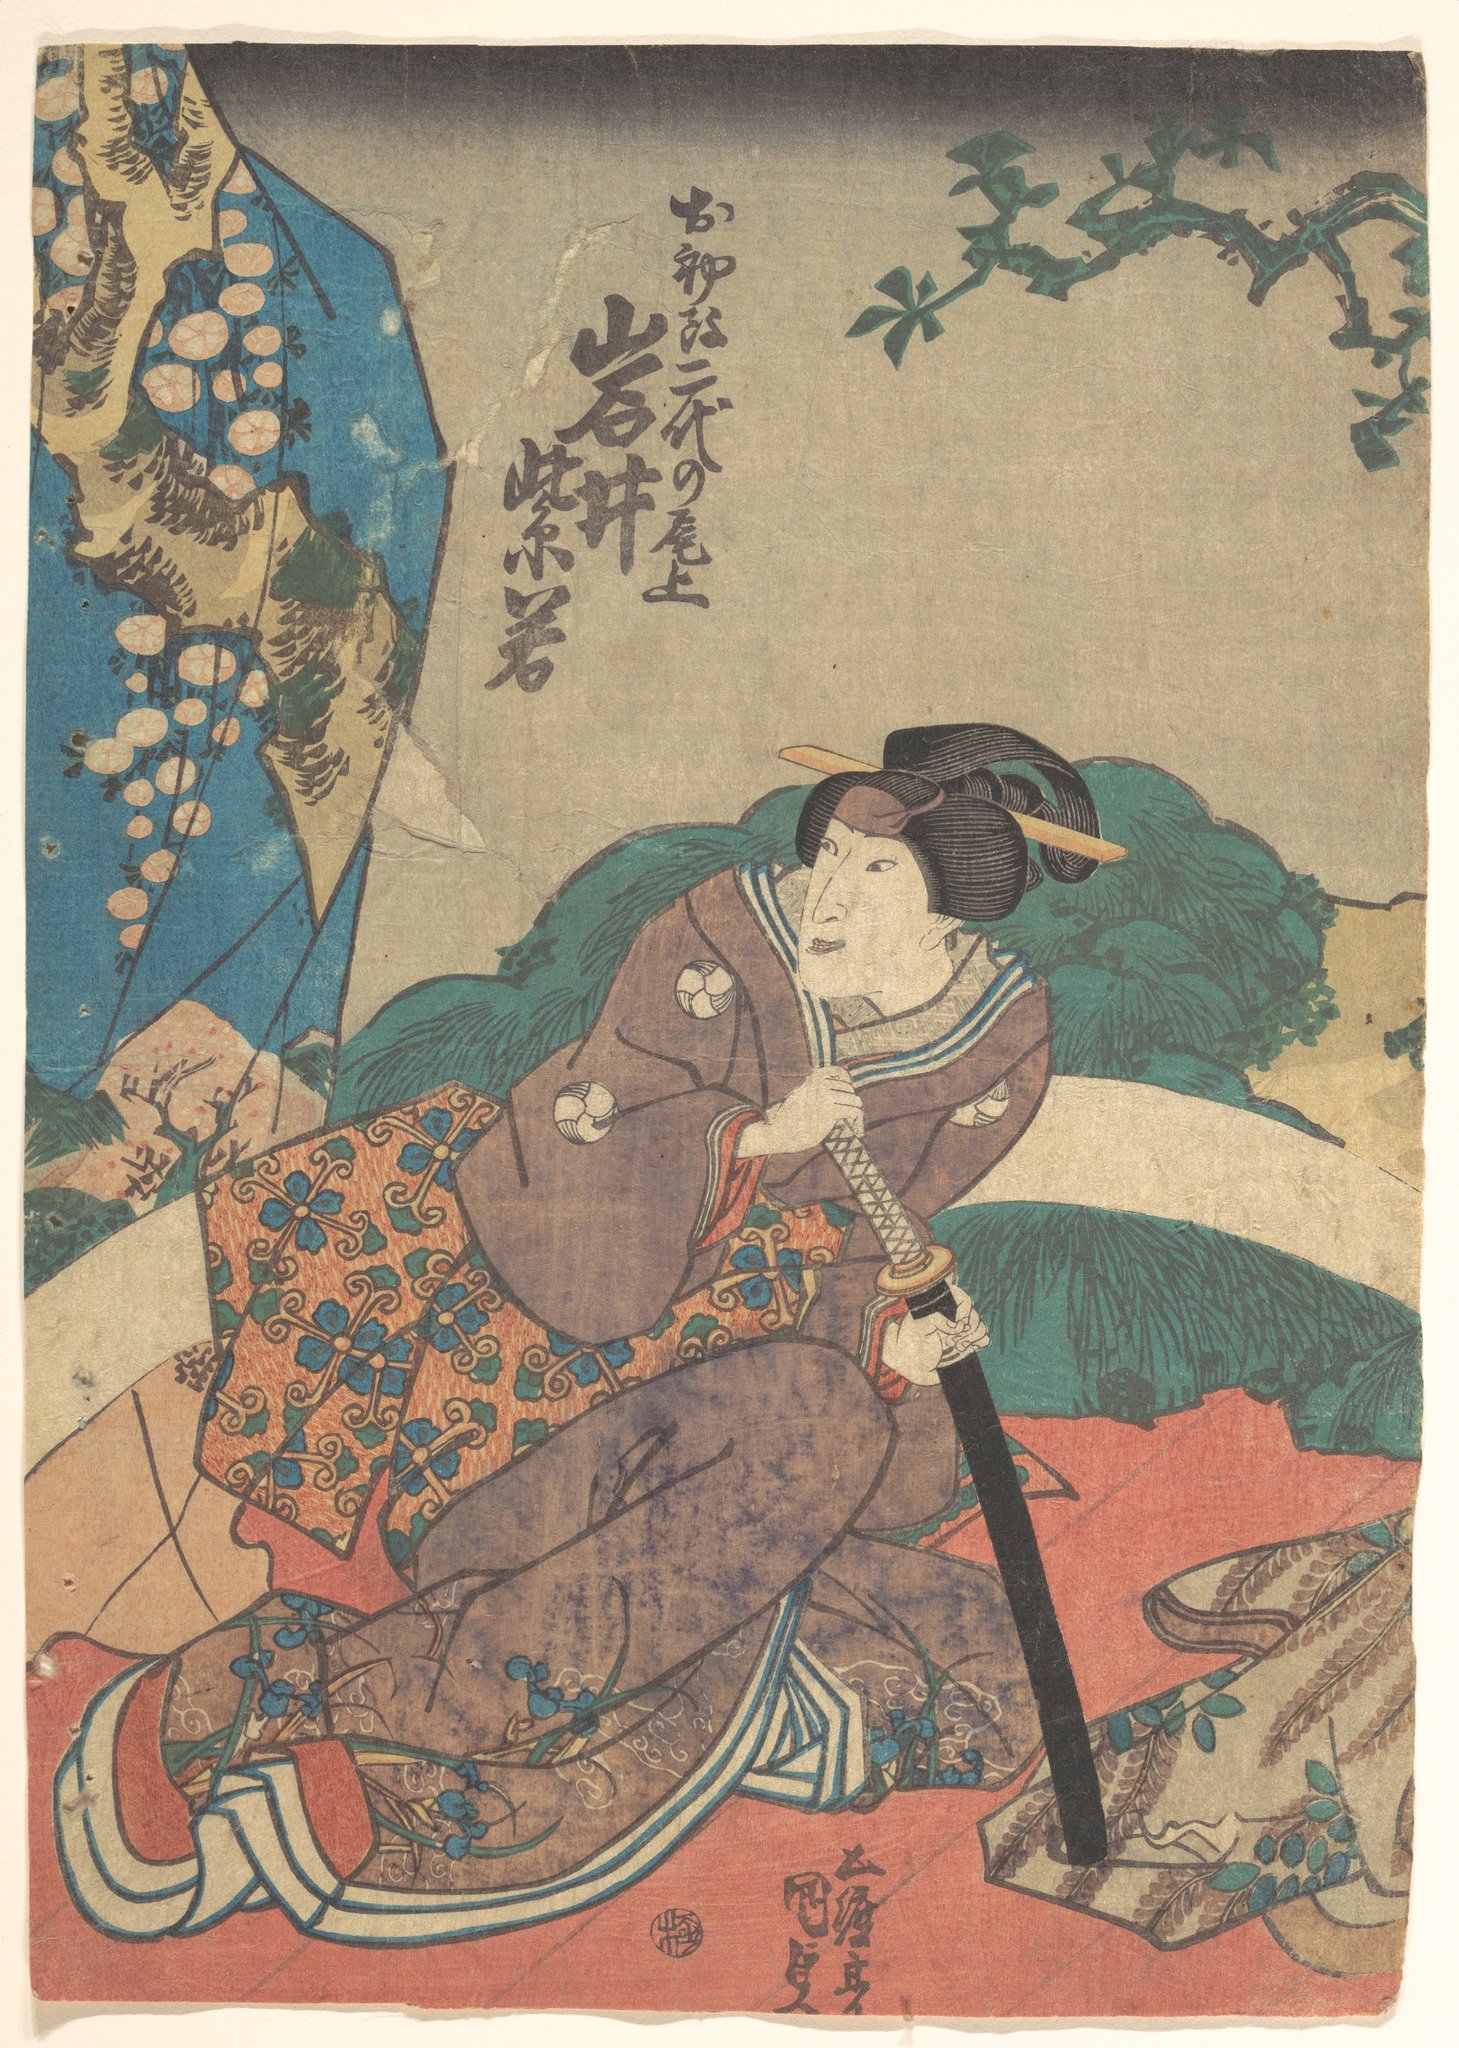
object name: print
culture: japanese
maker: utagawa kunisada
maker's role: artist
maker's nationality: japanese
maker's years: 1786-1864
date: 1801-1900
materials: ink, paper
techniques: woodblock print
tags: human figures,swords